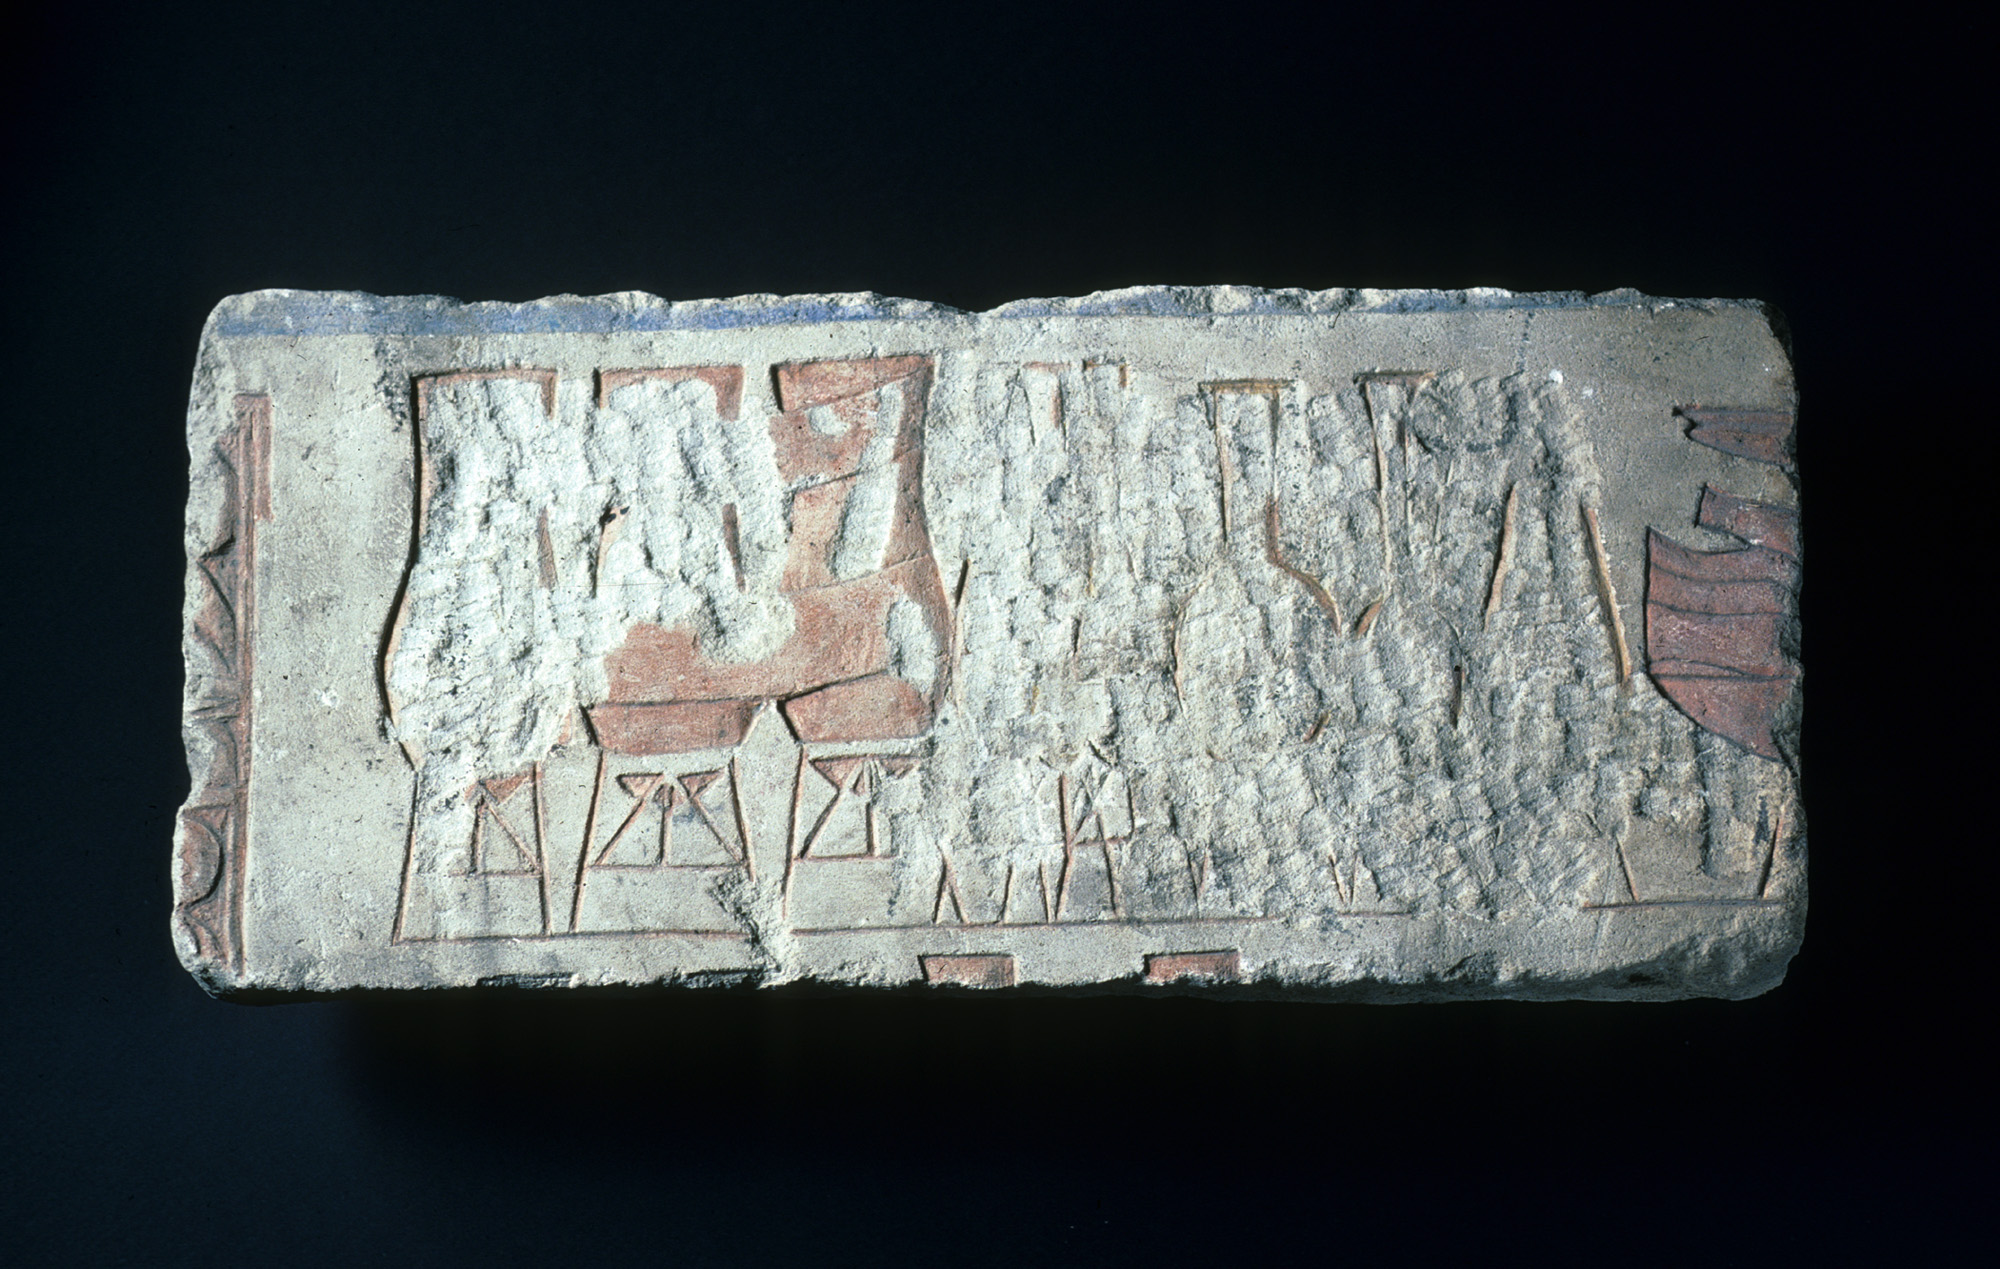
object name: talatat, jar on stand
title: Relief with jars on stands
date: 1353-1336 BCE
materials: limestone, paint